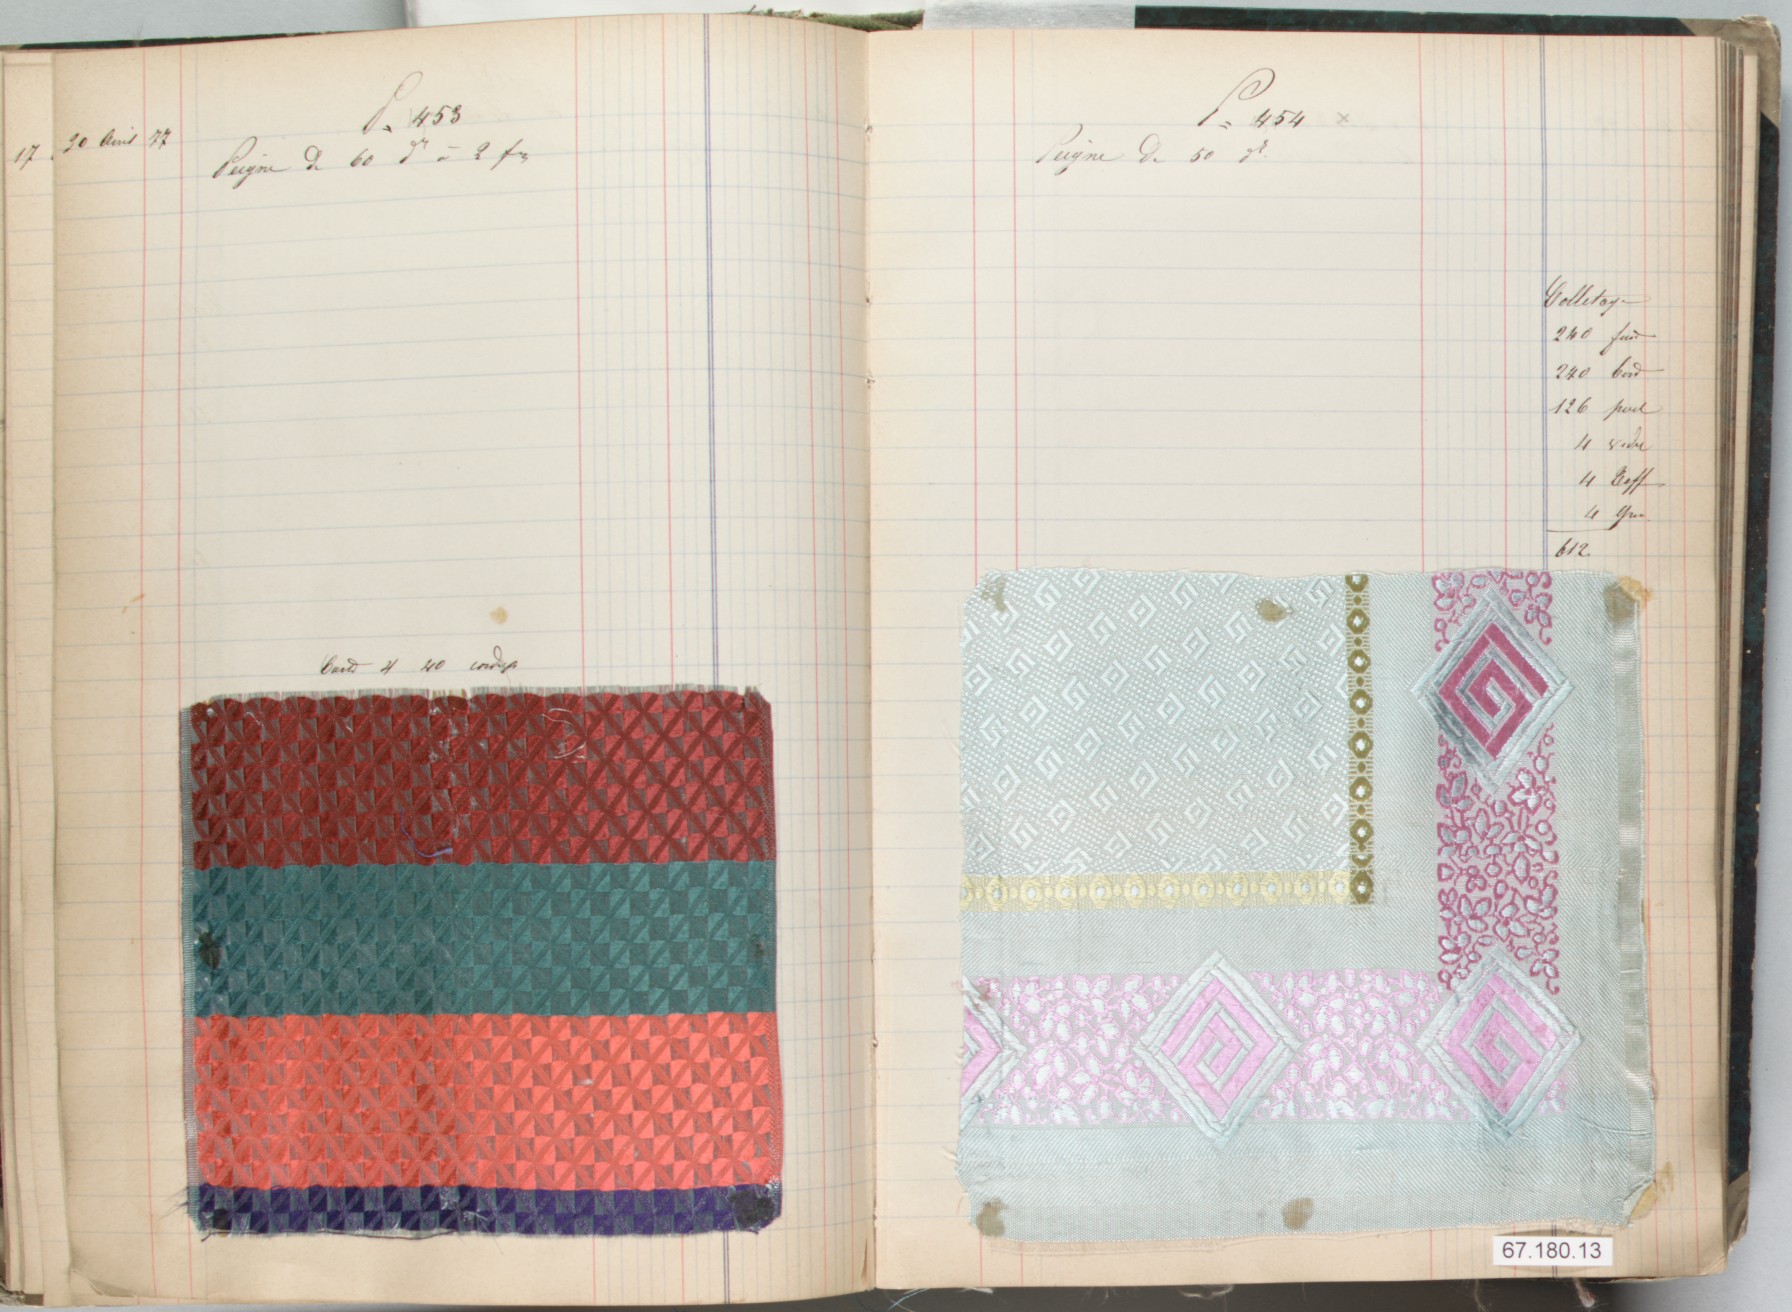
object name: sample book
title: Textile Sample Book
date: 1876-1878